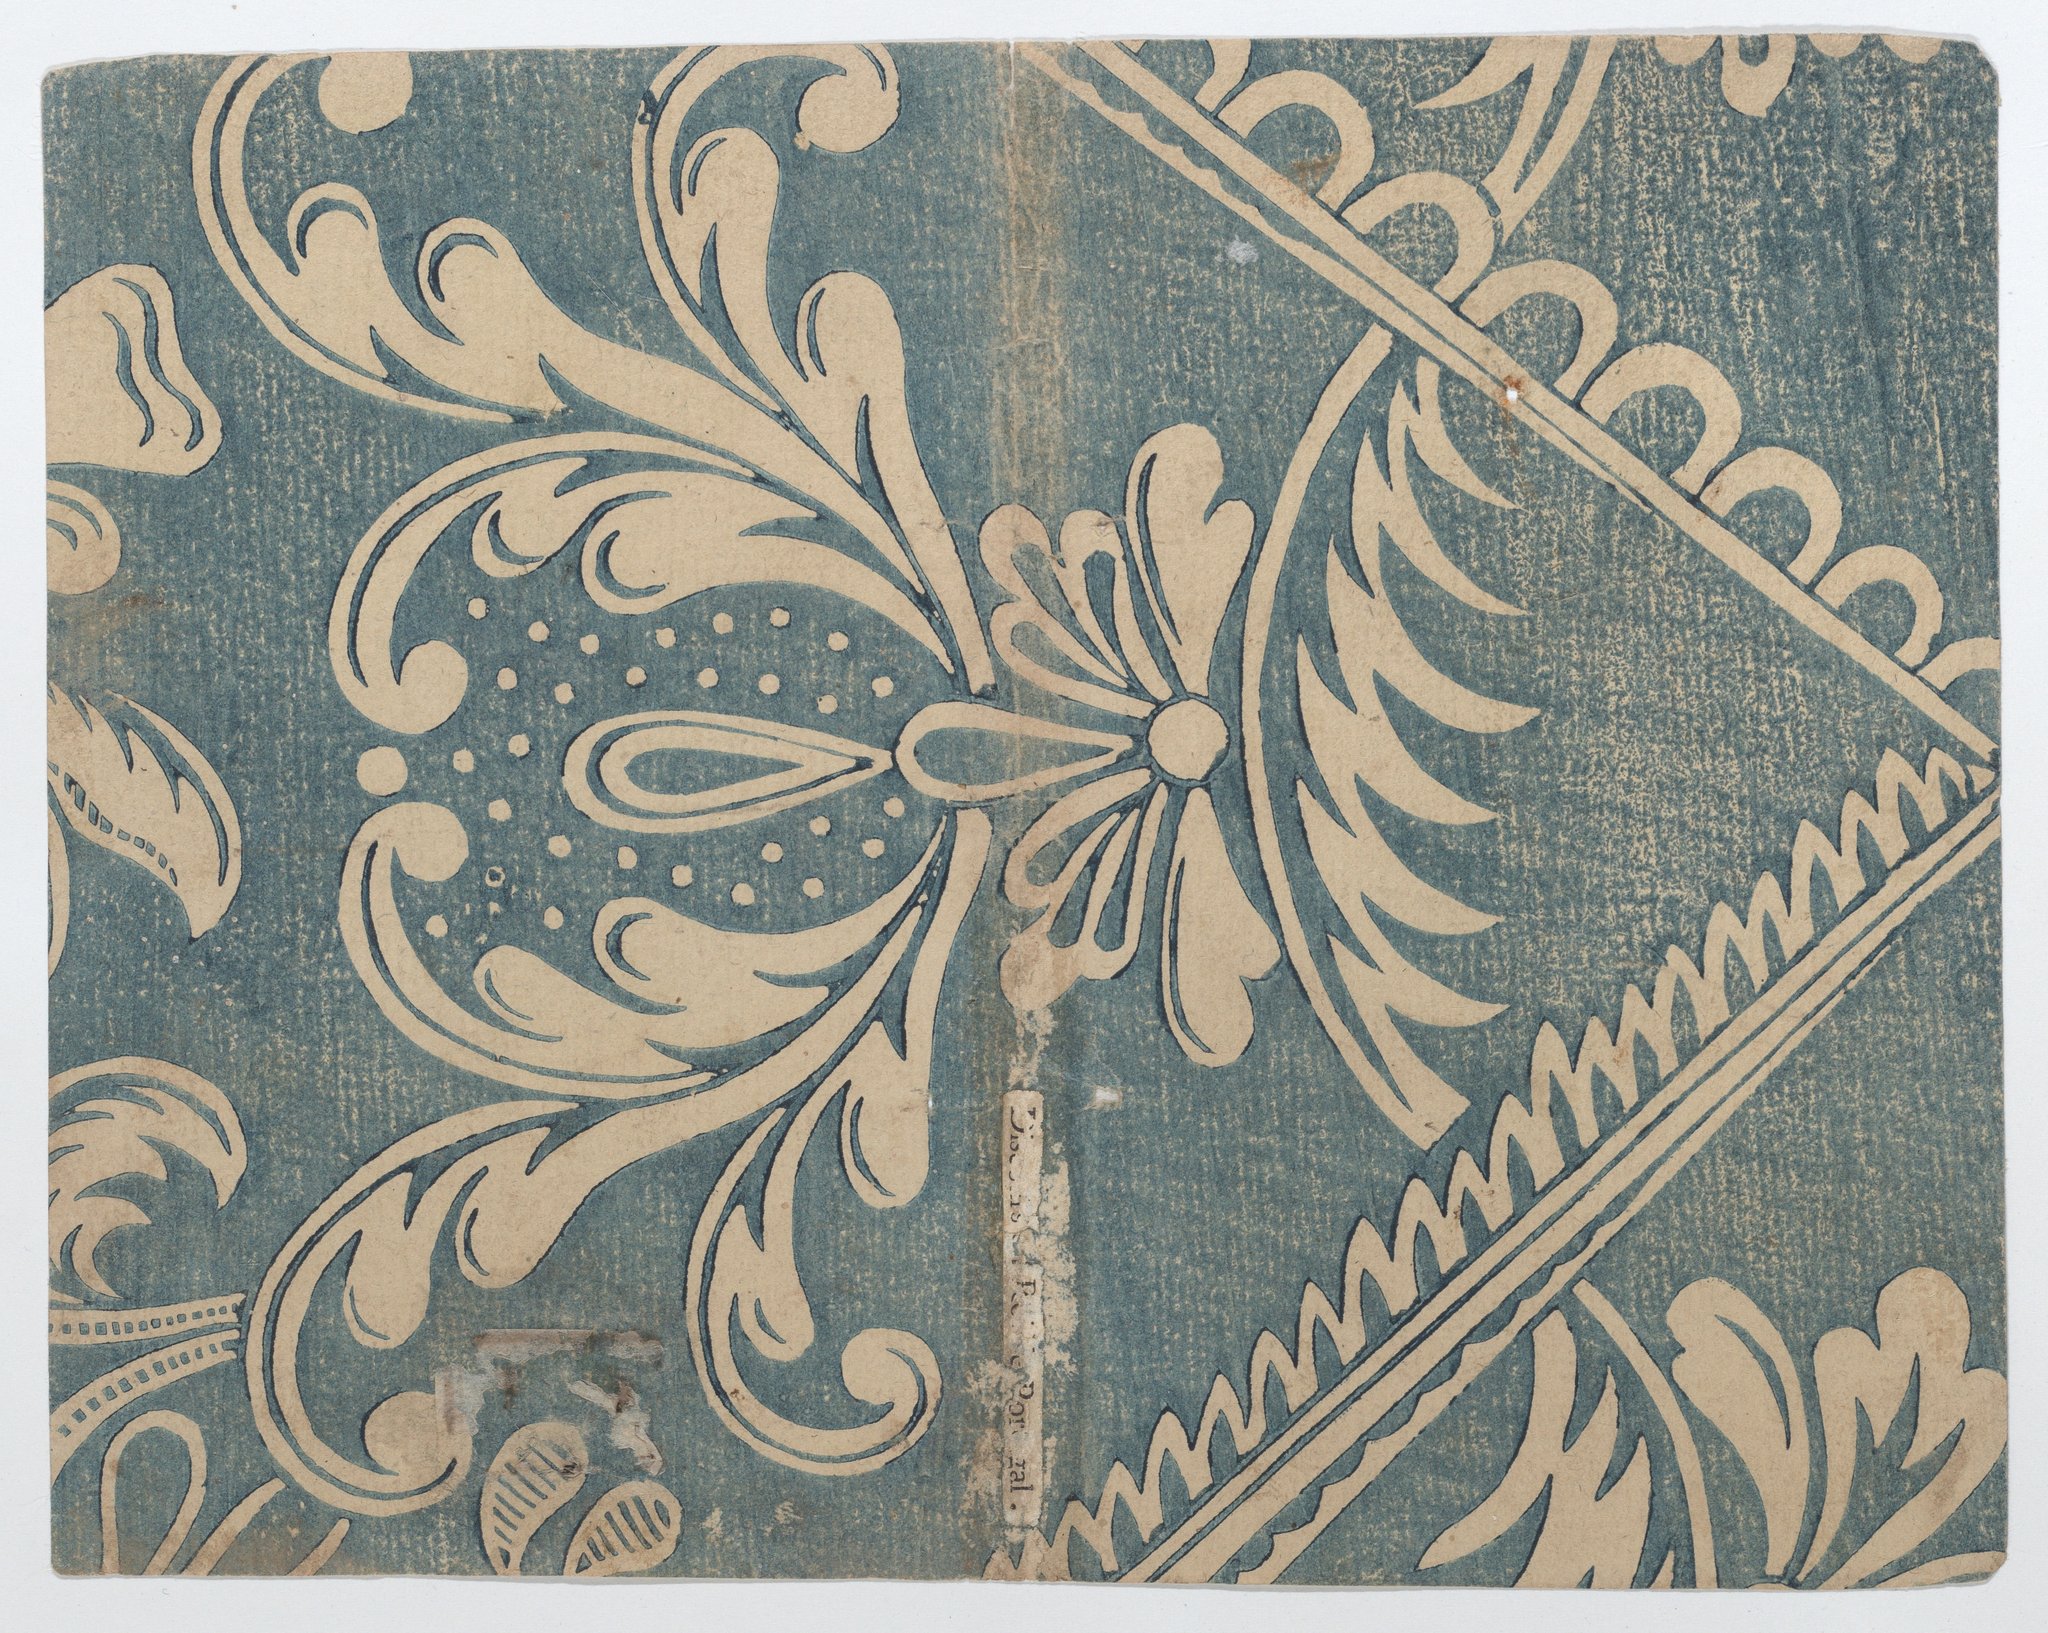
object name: print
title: Book cover with rinceau and floral patterns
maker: Anonymous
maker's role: artist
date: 1701-1800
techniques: relief print